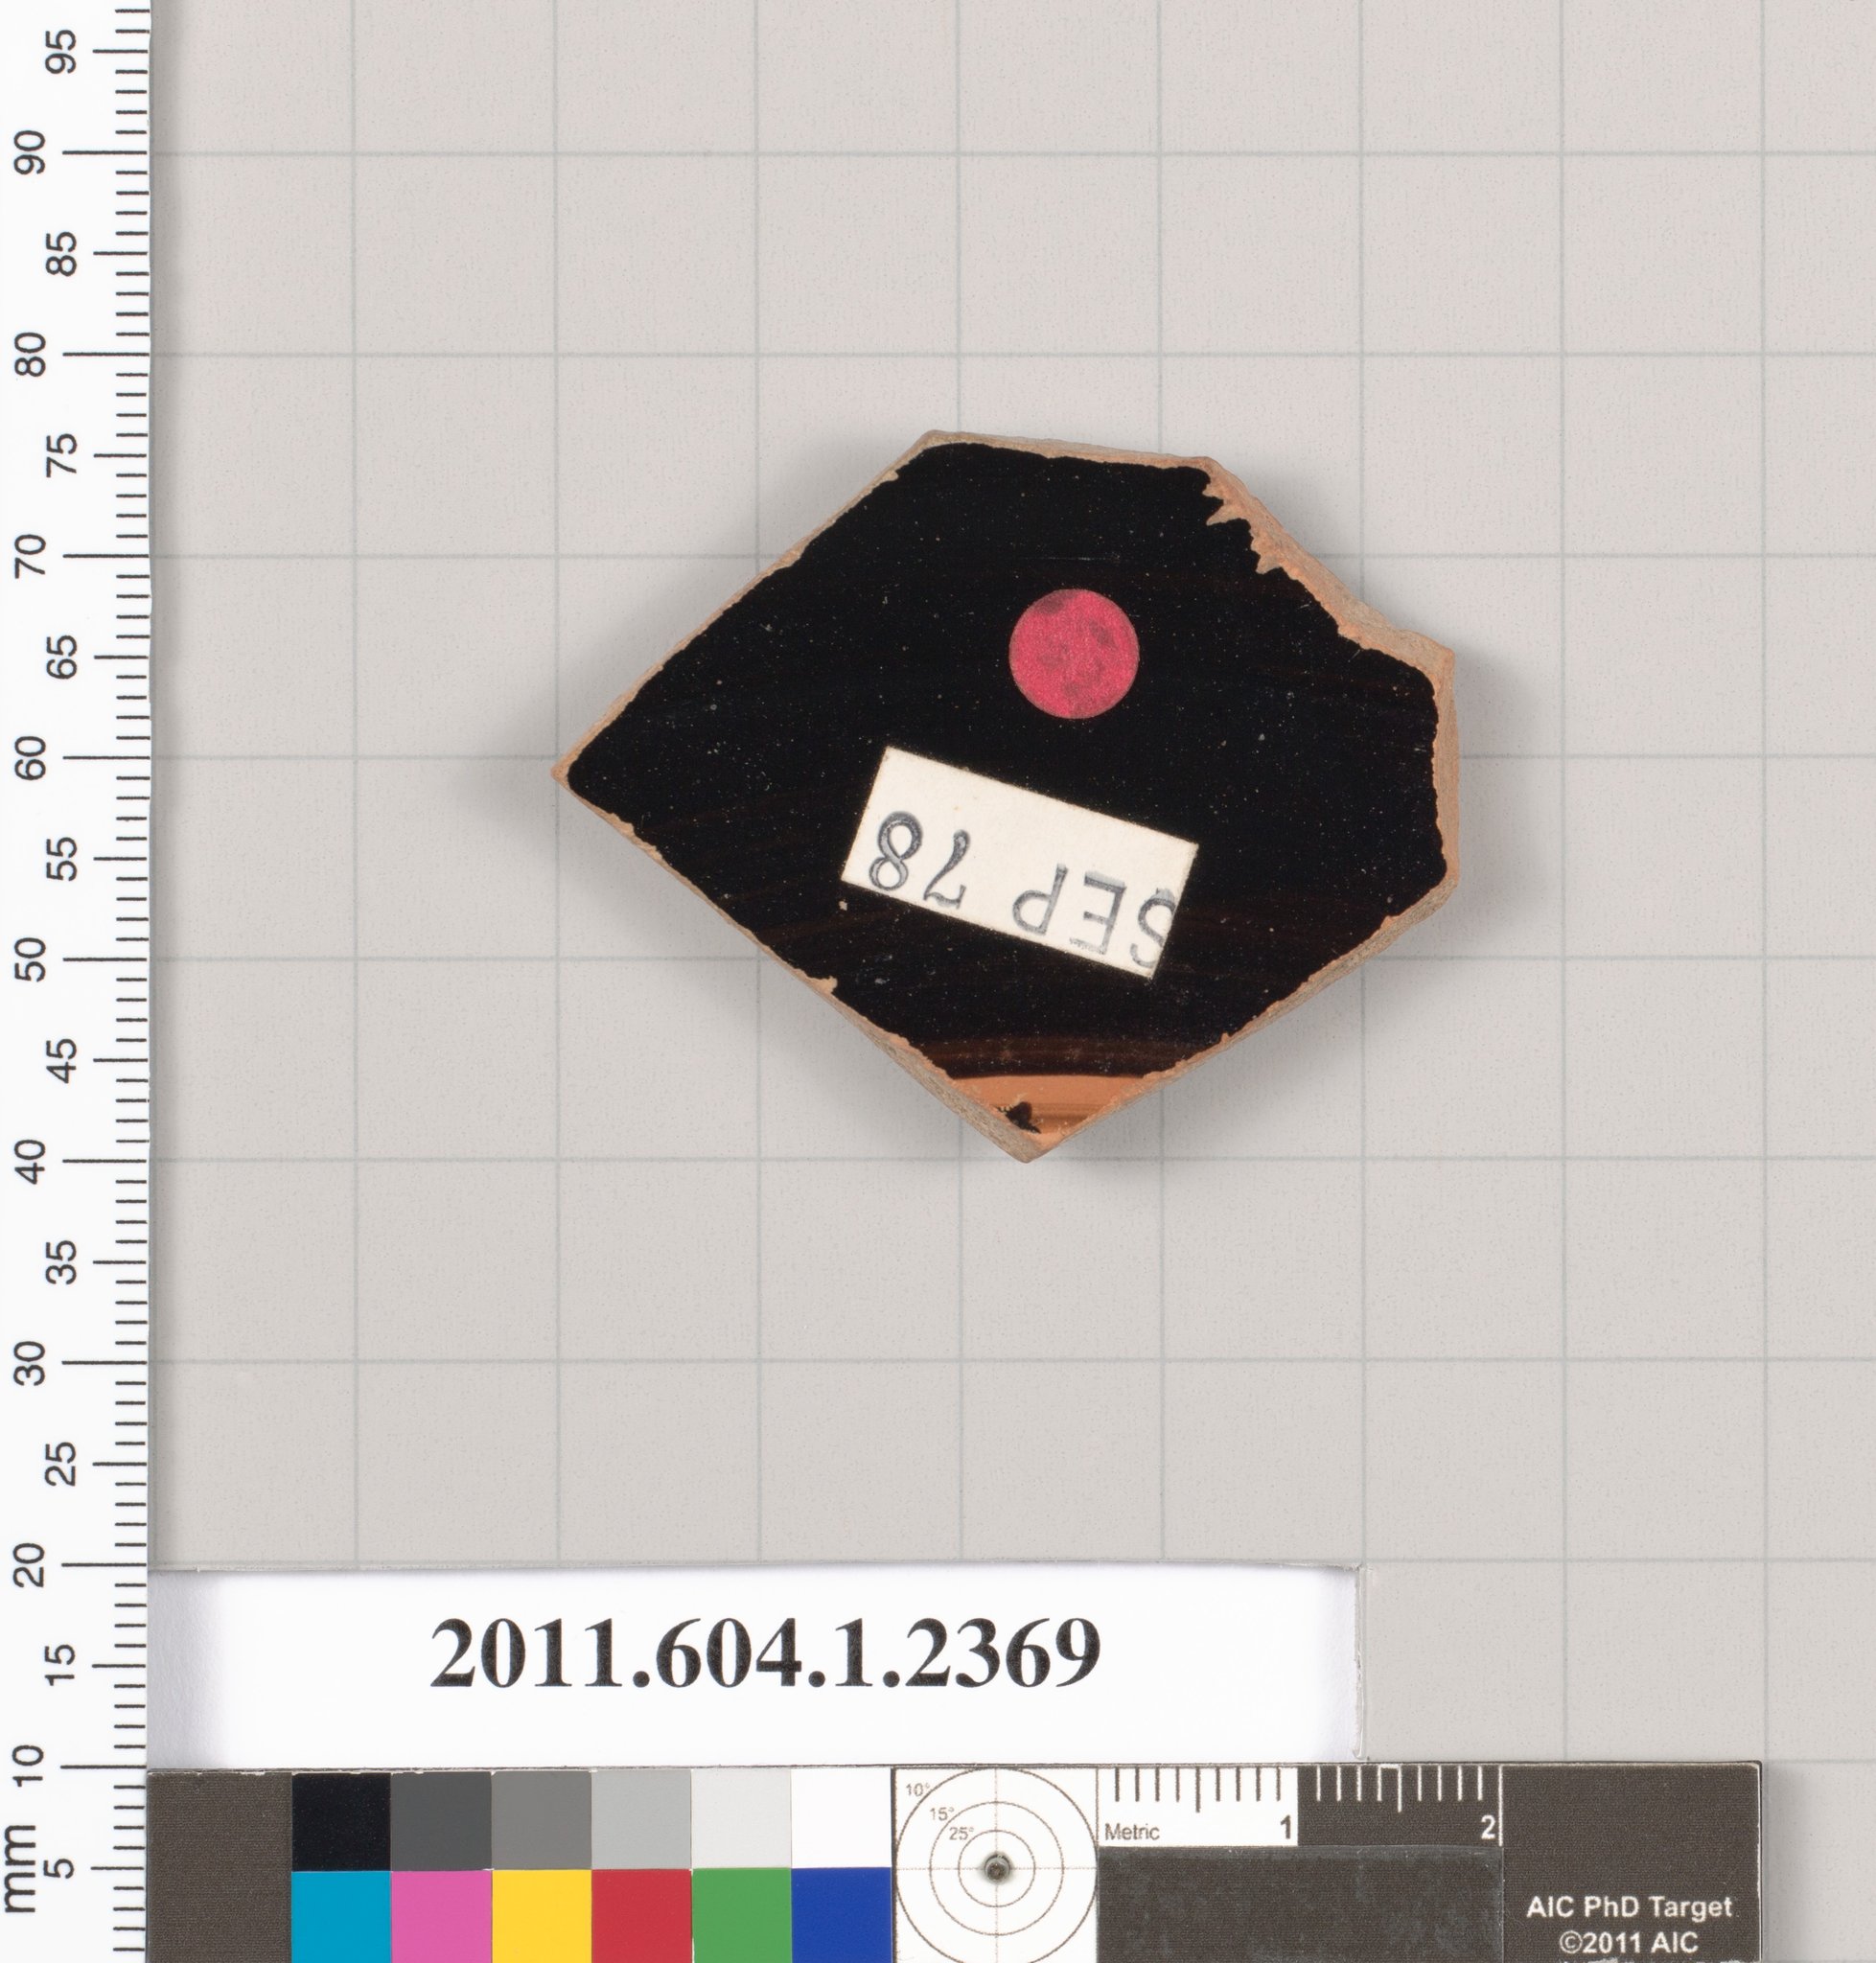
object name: kylix fragment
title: Terracotta fragment of a kylix (drinking cup)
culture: greek, attic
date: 475-451 BCE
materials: terracotta